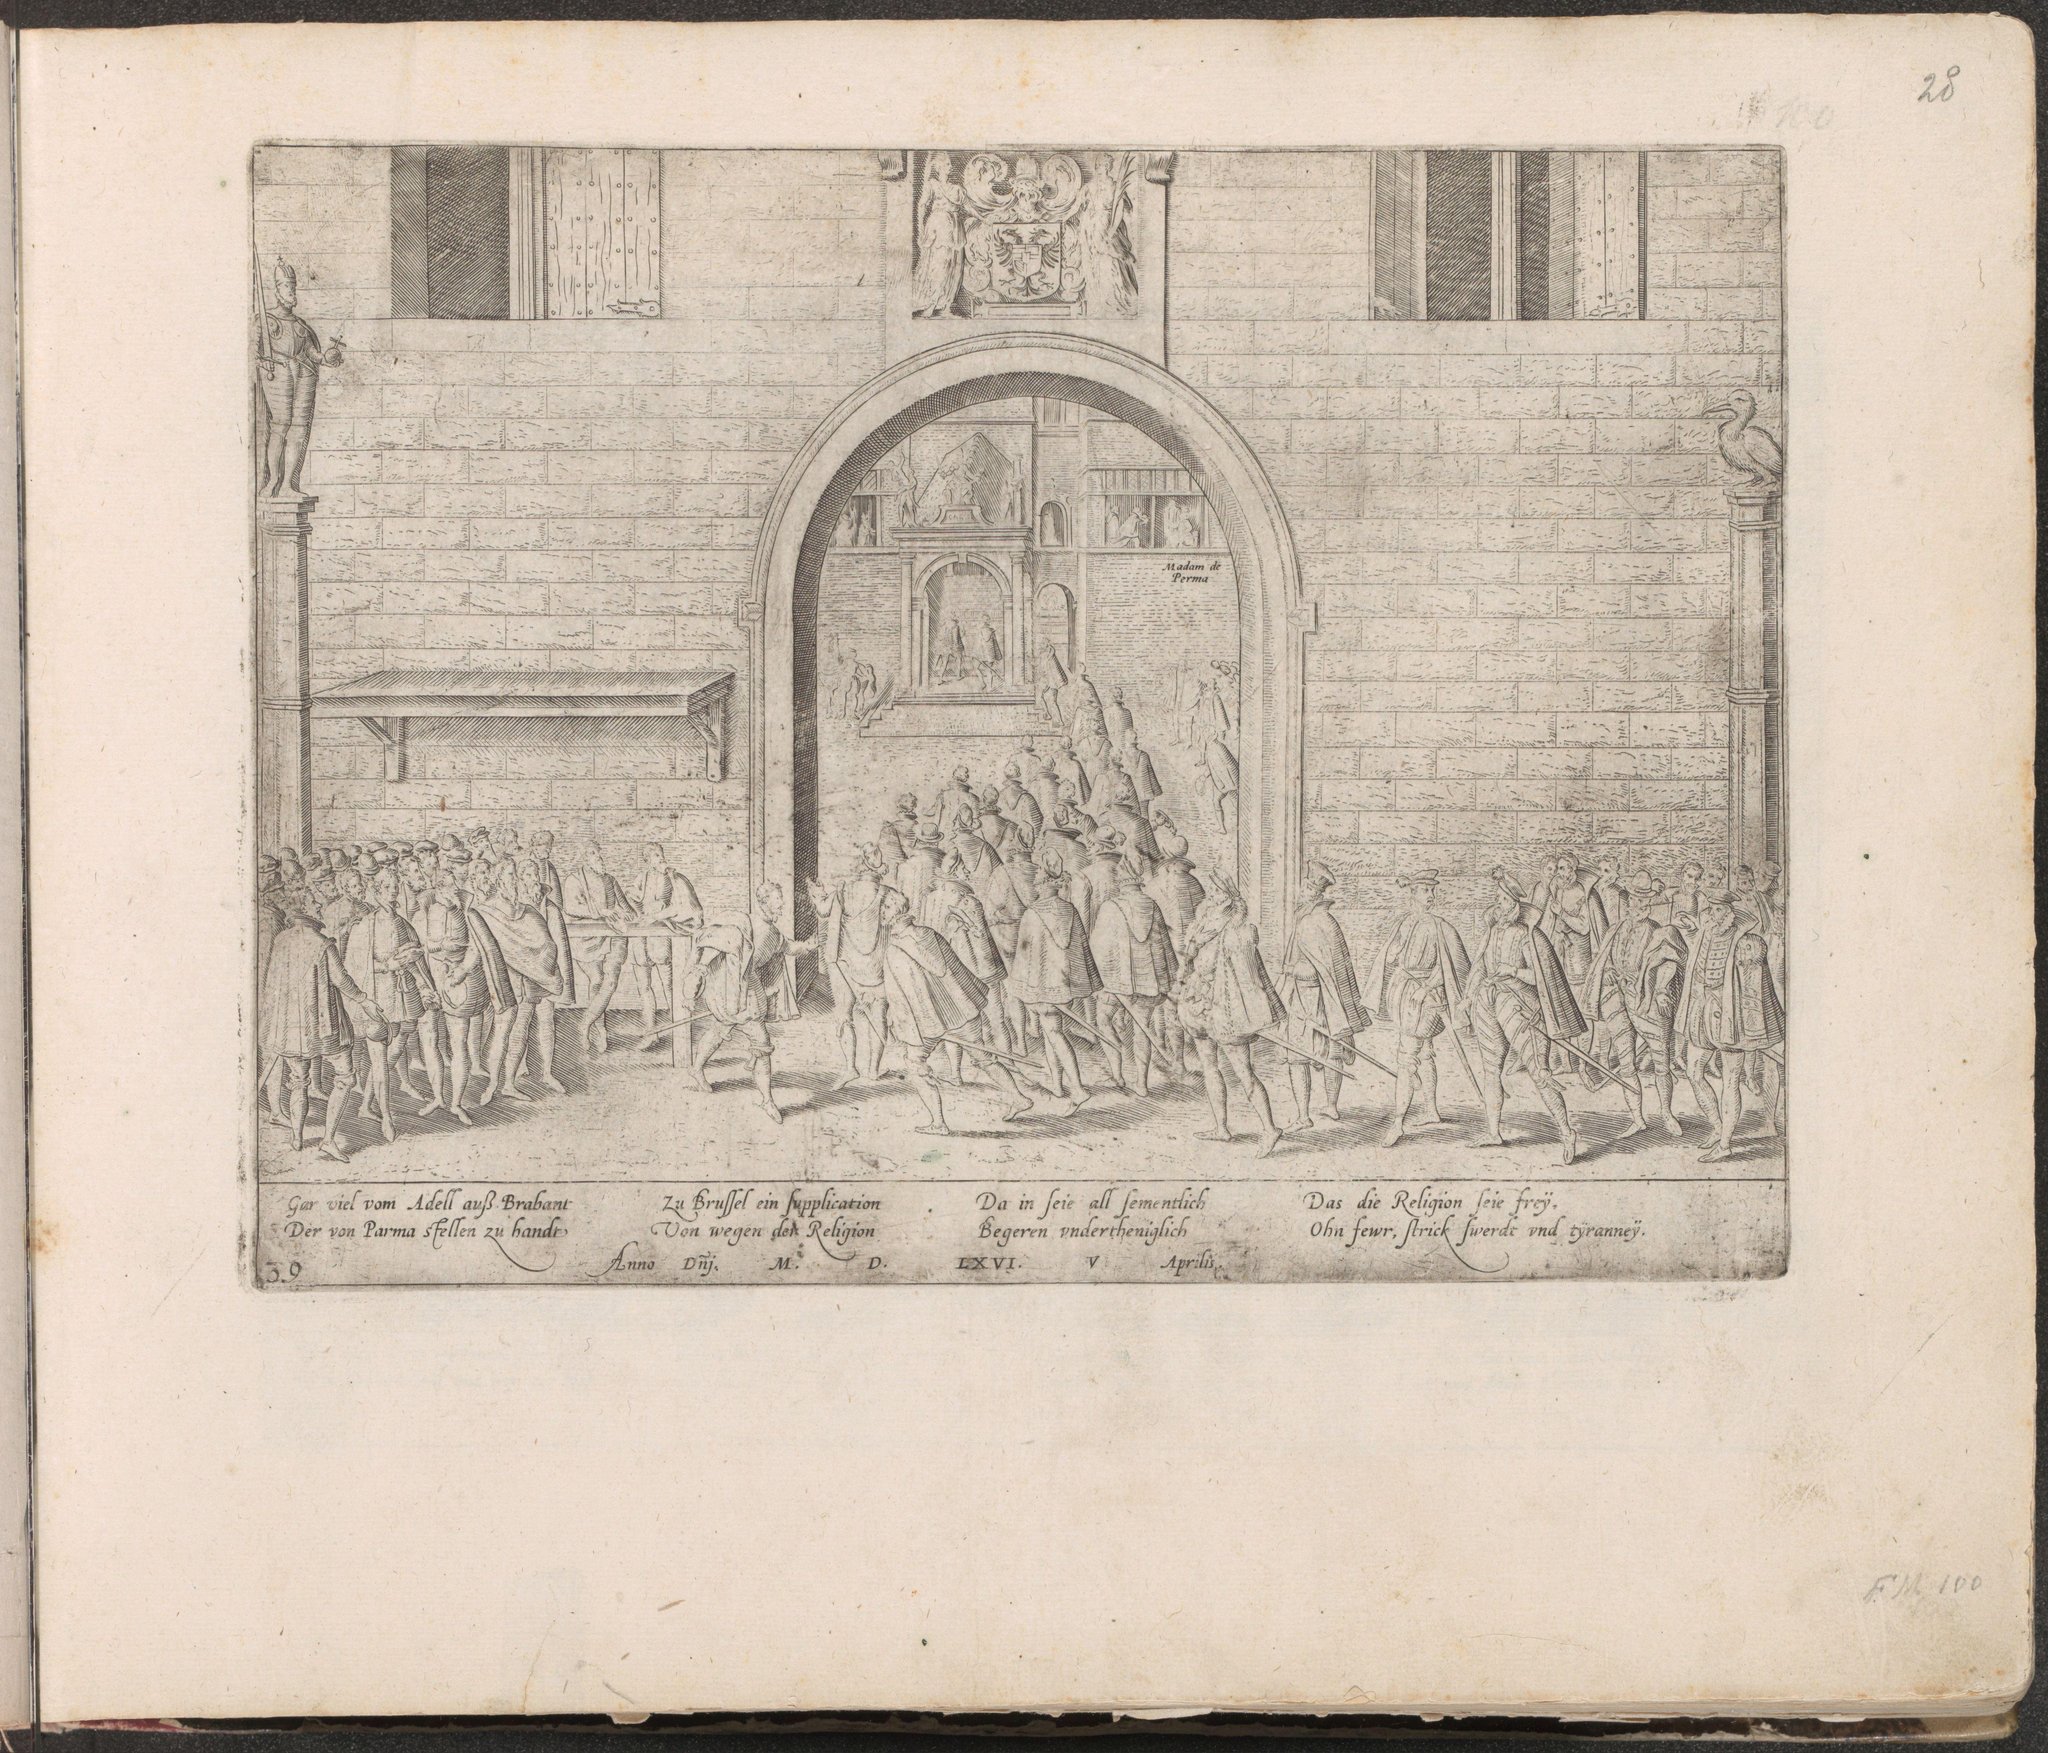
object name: print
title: Serie 5: Nederlandse Gebeurtenissen, 1566-1570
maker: frans hogenberg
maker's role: print maker, publisher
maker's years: 1538-1590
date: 1568-1572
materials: paper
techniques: etching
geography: cologne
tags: ortona, landvoogd, landvoogdes der nederlanden margaretha van parma, paleis op de koudenberg, tachtigjarige oorlog, smeekschrift der edelen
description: Aanbieding van het Smeekschrift van de edelen. Een stoet van edelen trekt door de poort naar het paleis te Brussel waar het Smeekschrift aangeboden wordt aan Margaretha van Parma, 5 april 1566. Met onderschrift van 8 regels in het Duits. Linksonder genummerd: 39. De prent maakt deel uit van een album.